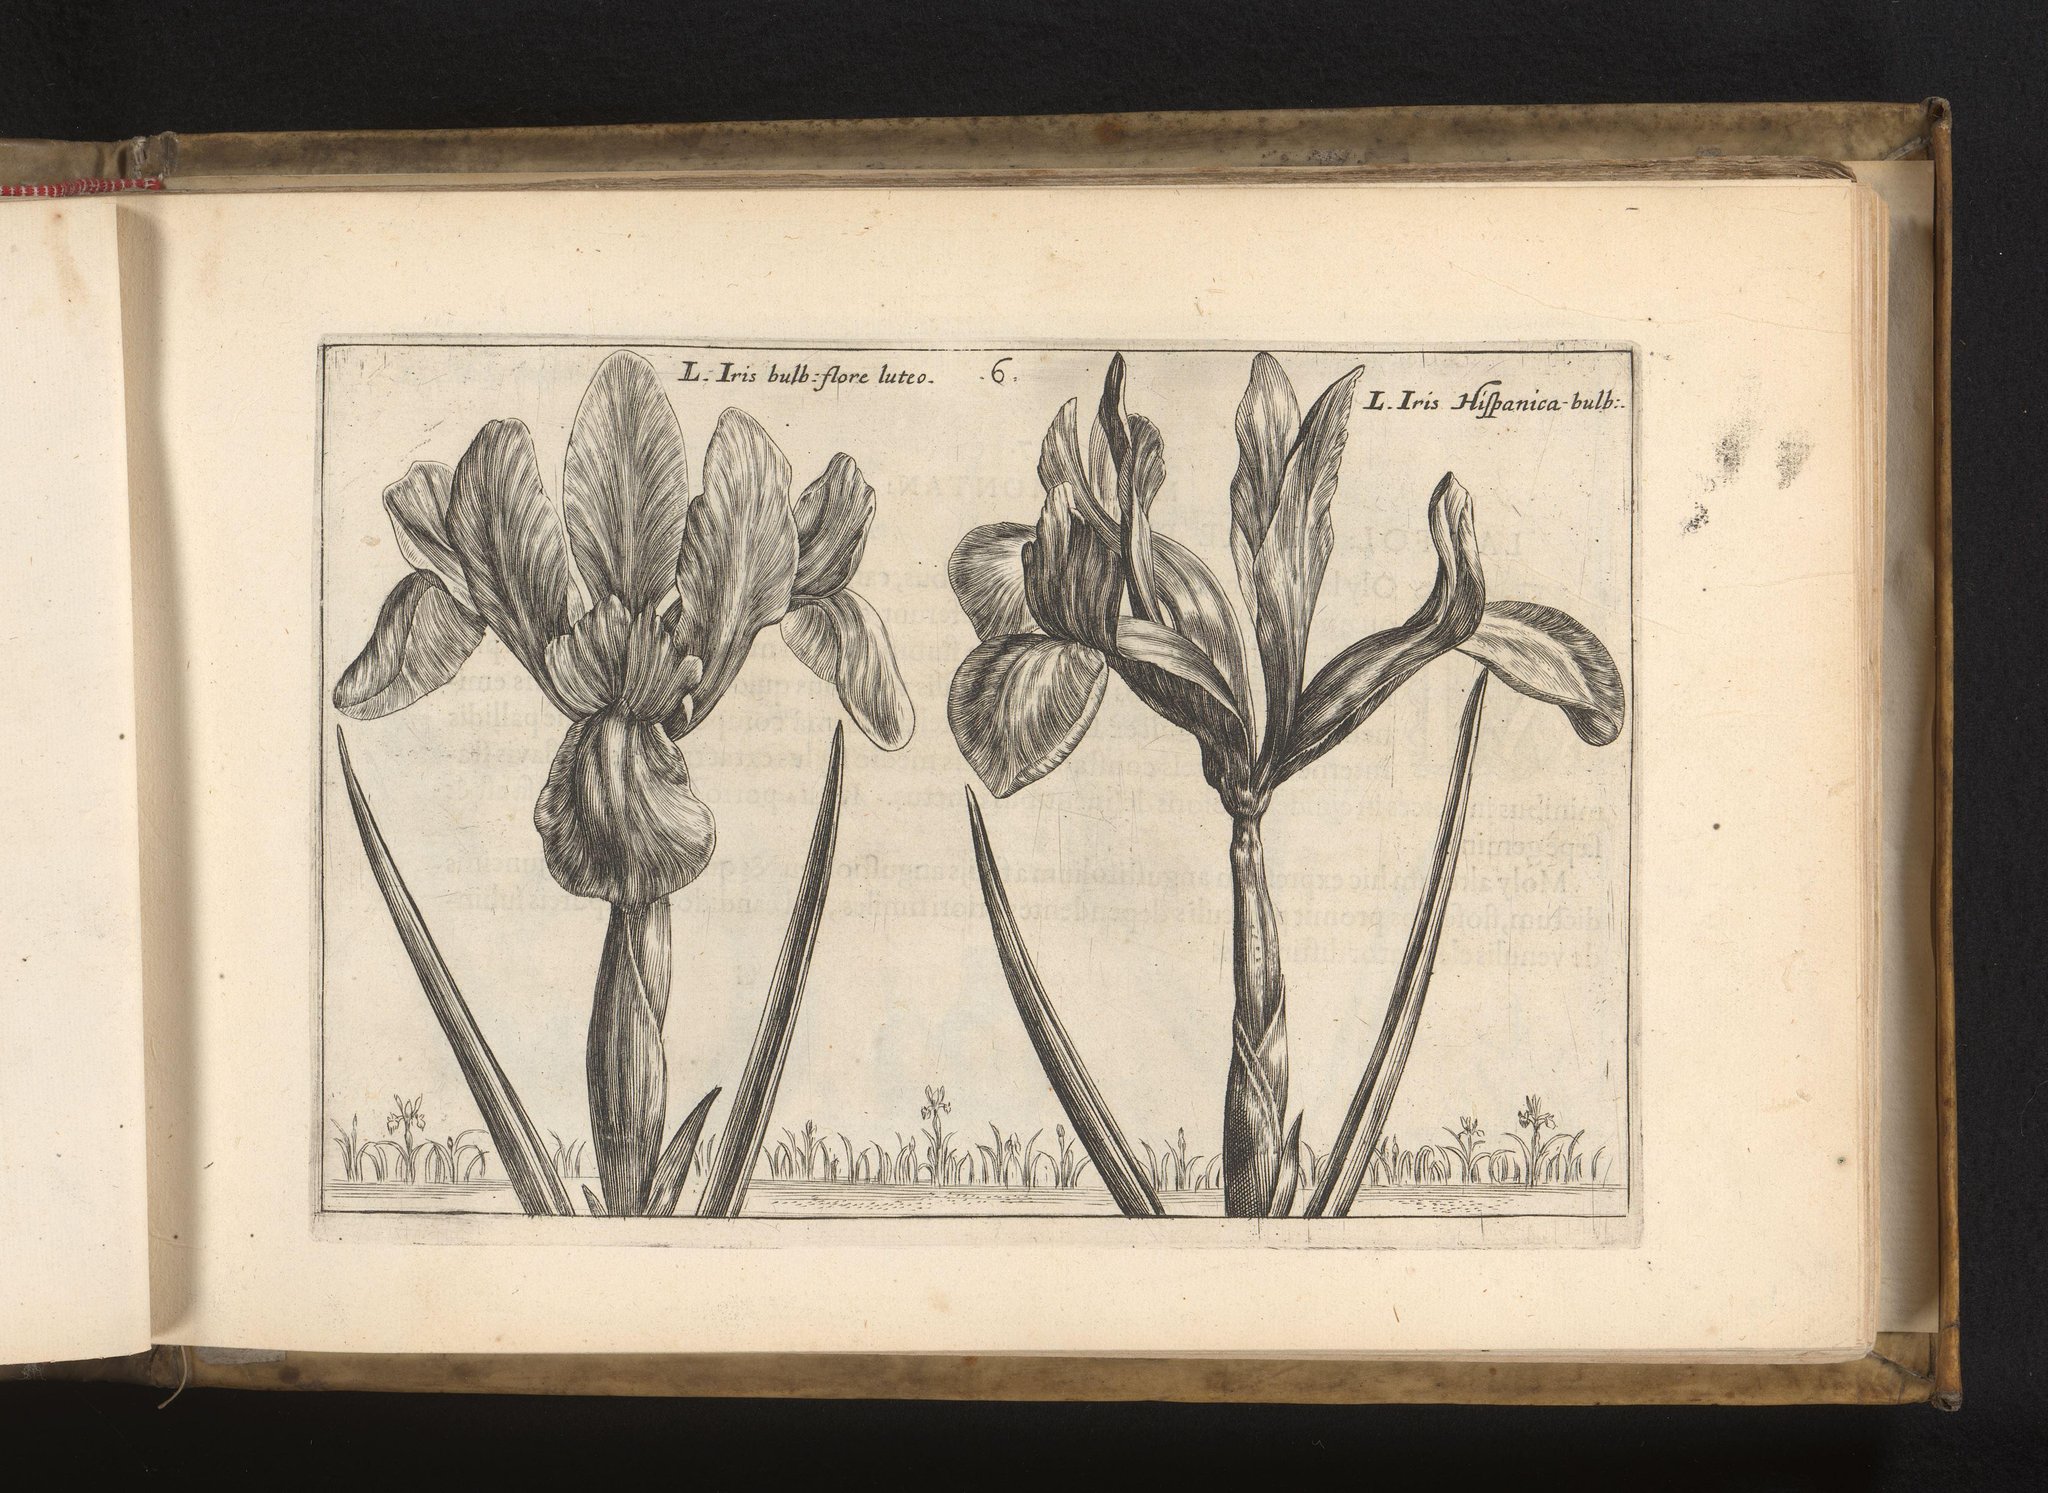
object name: page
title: Iris Hispanica bulb.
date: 1617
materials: paper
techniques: engraving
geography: arnhem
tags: flowers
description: Prent uit: Passe, Crispijn van de (II). Hortus floridus in quo rariorum & minus vulgarium florum icones ad vivam veramque formam. Arnhem: Johannes Janssonius, 1617.